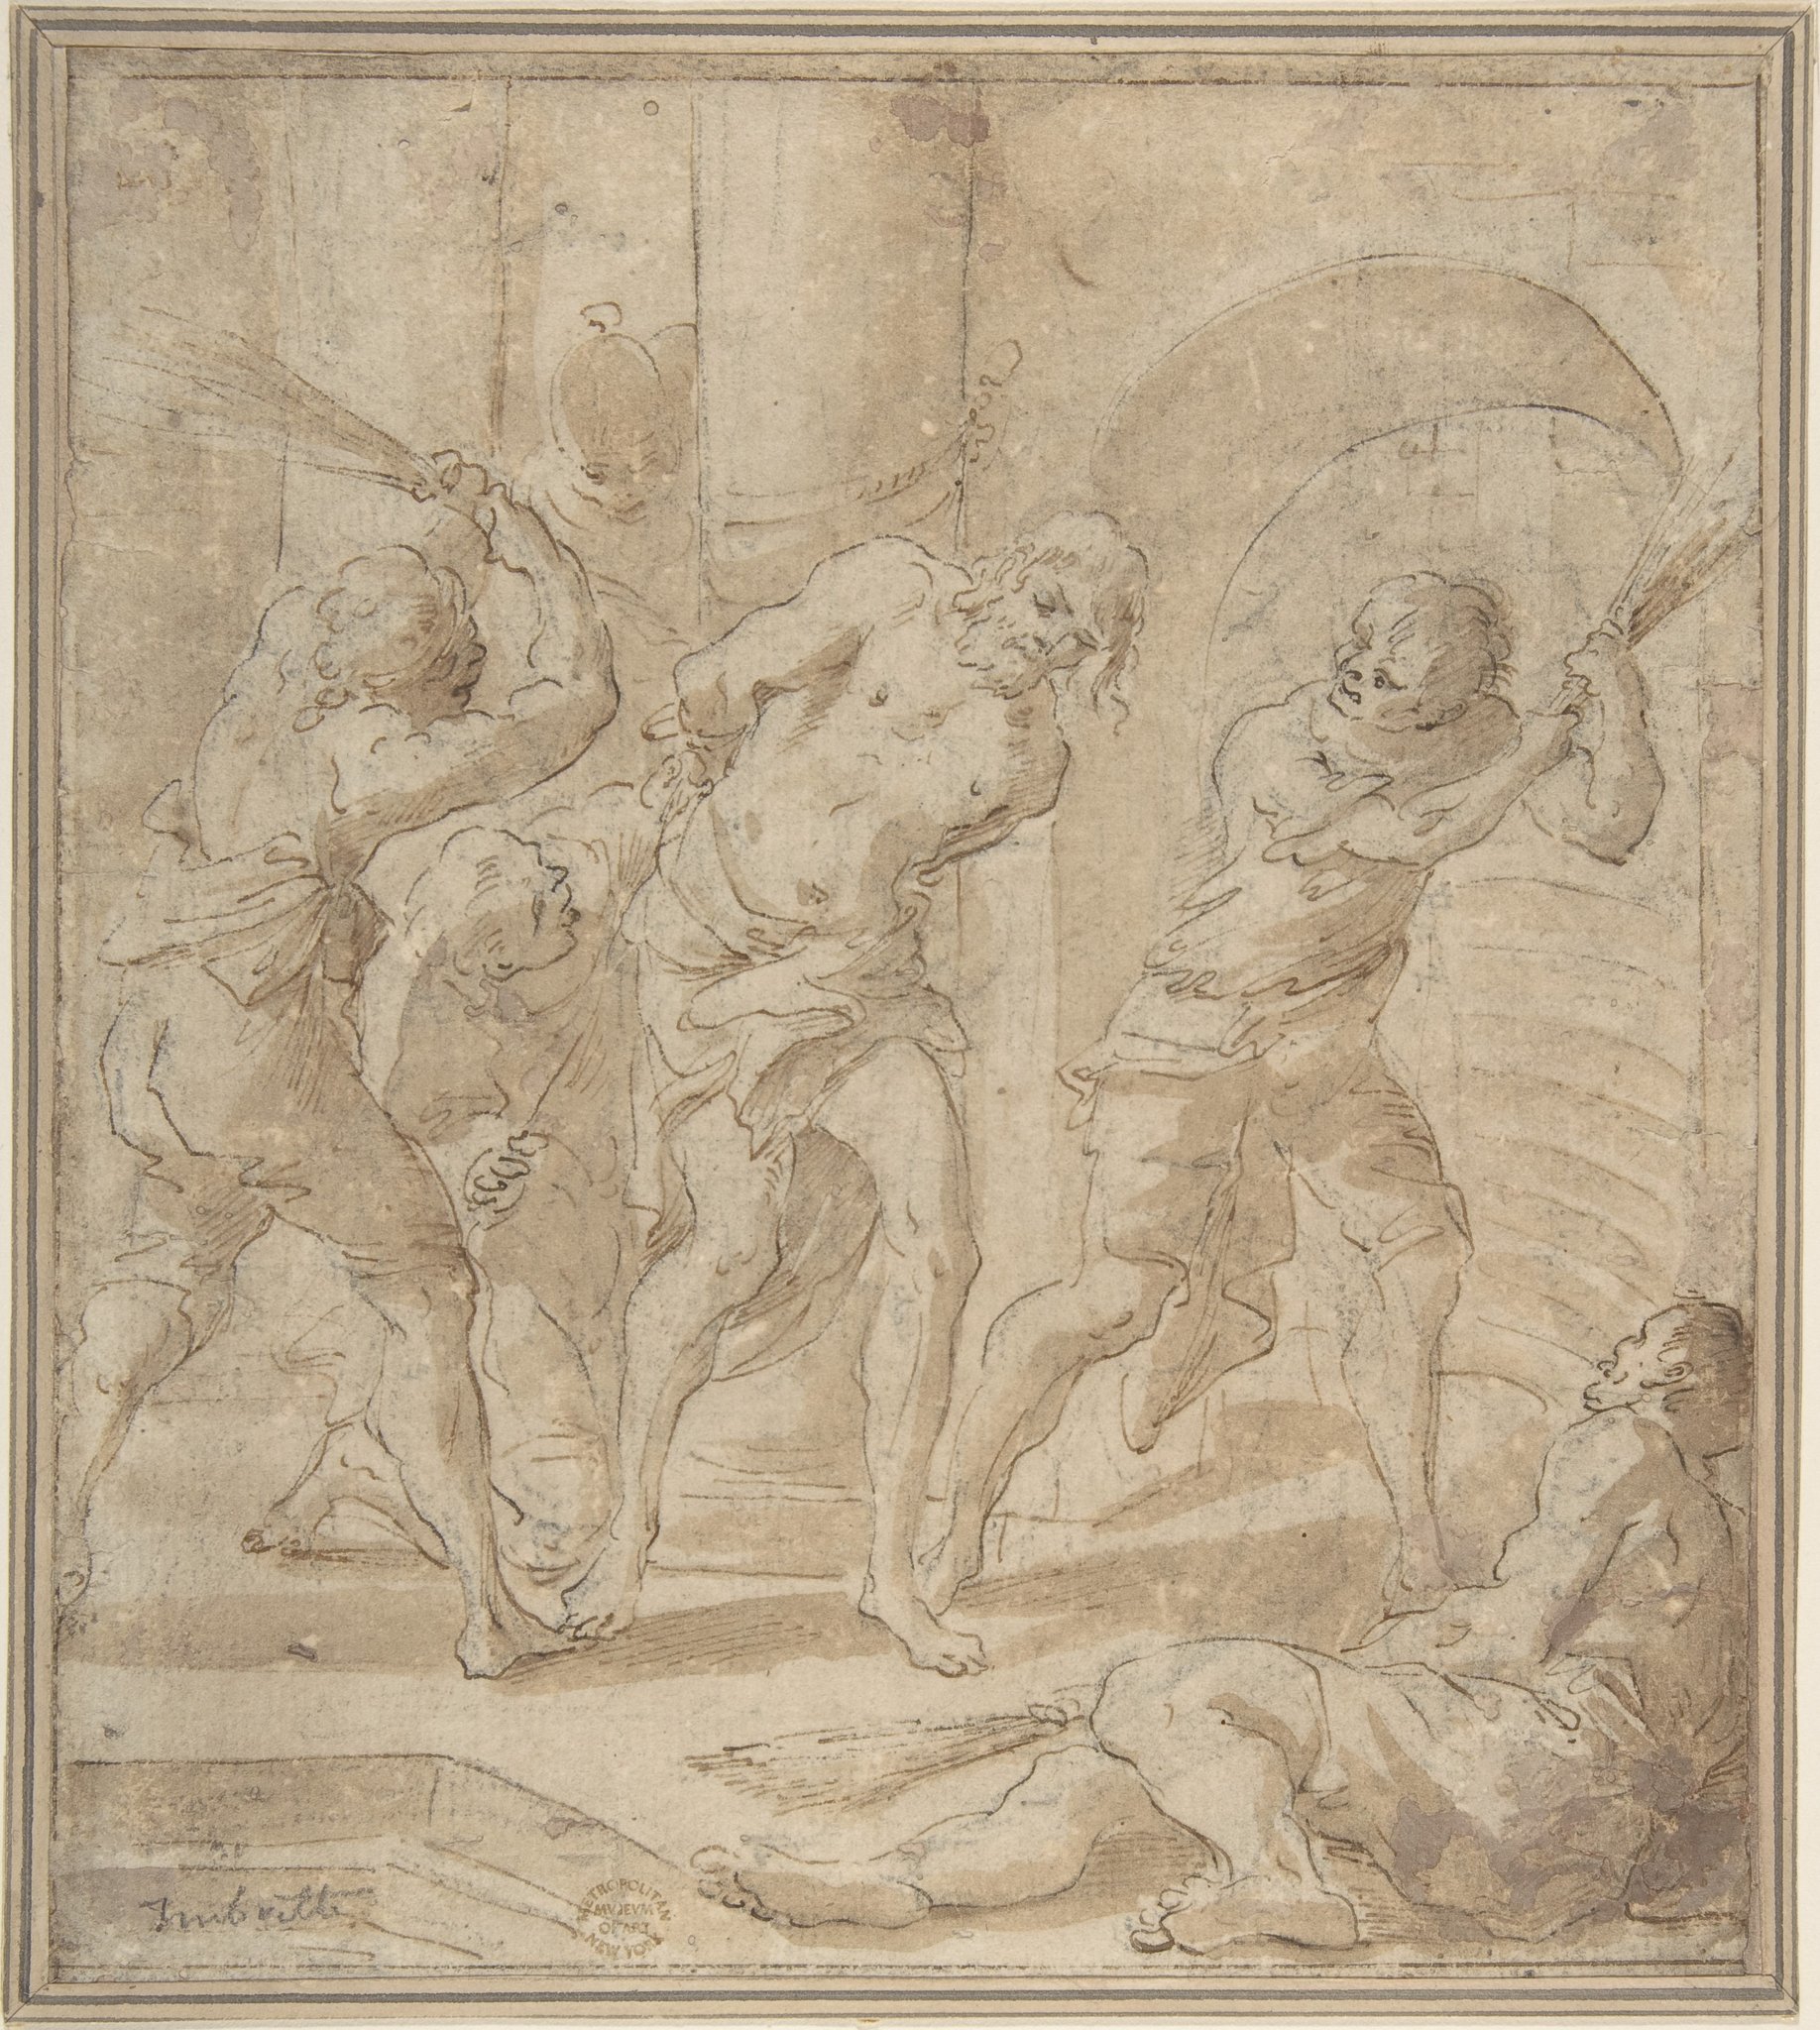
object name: drawing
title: Flagellation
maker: anonymous, italian, venetian, 18th century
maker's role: artist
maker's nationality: italian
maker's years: 1700-1800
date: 1701-1800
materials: ink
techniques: pen, wash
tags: suffering,men,punishment